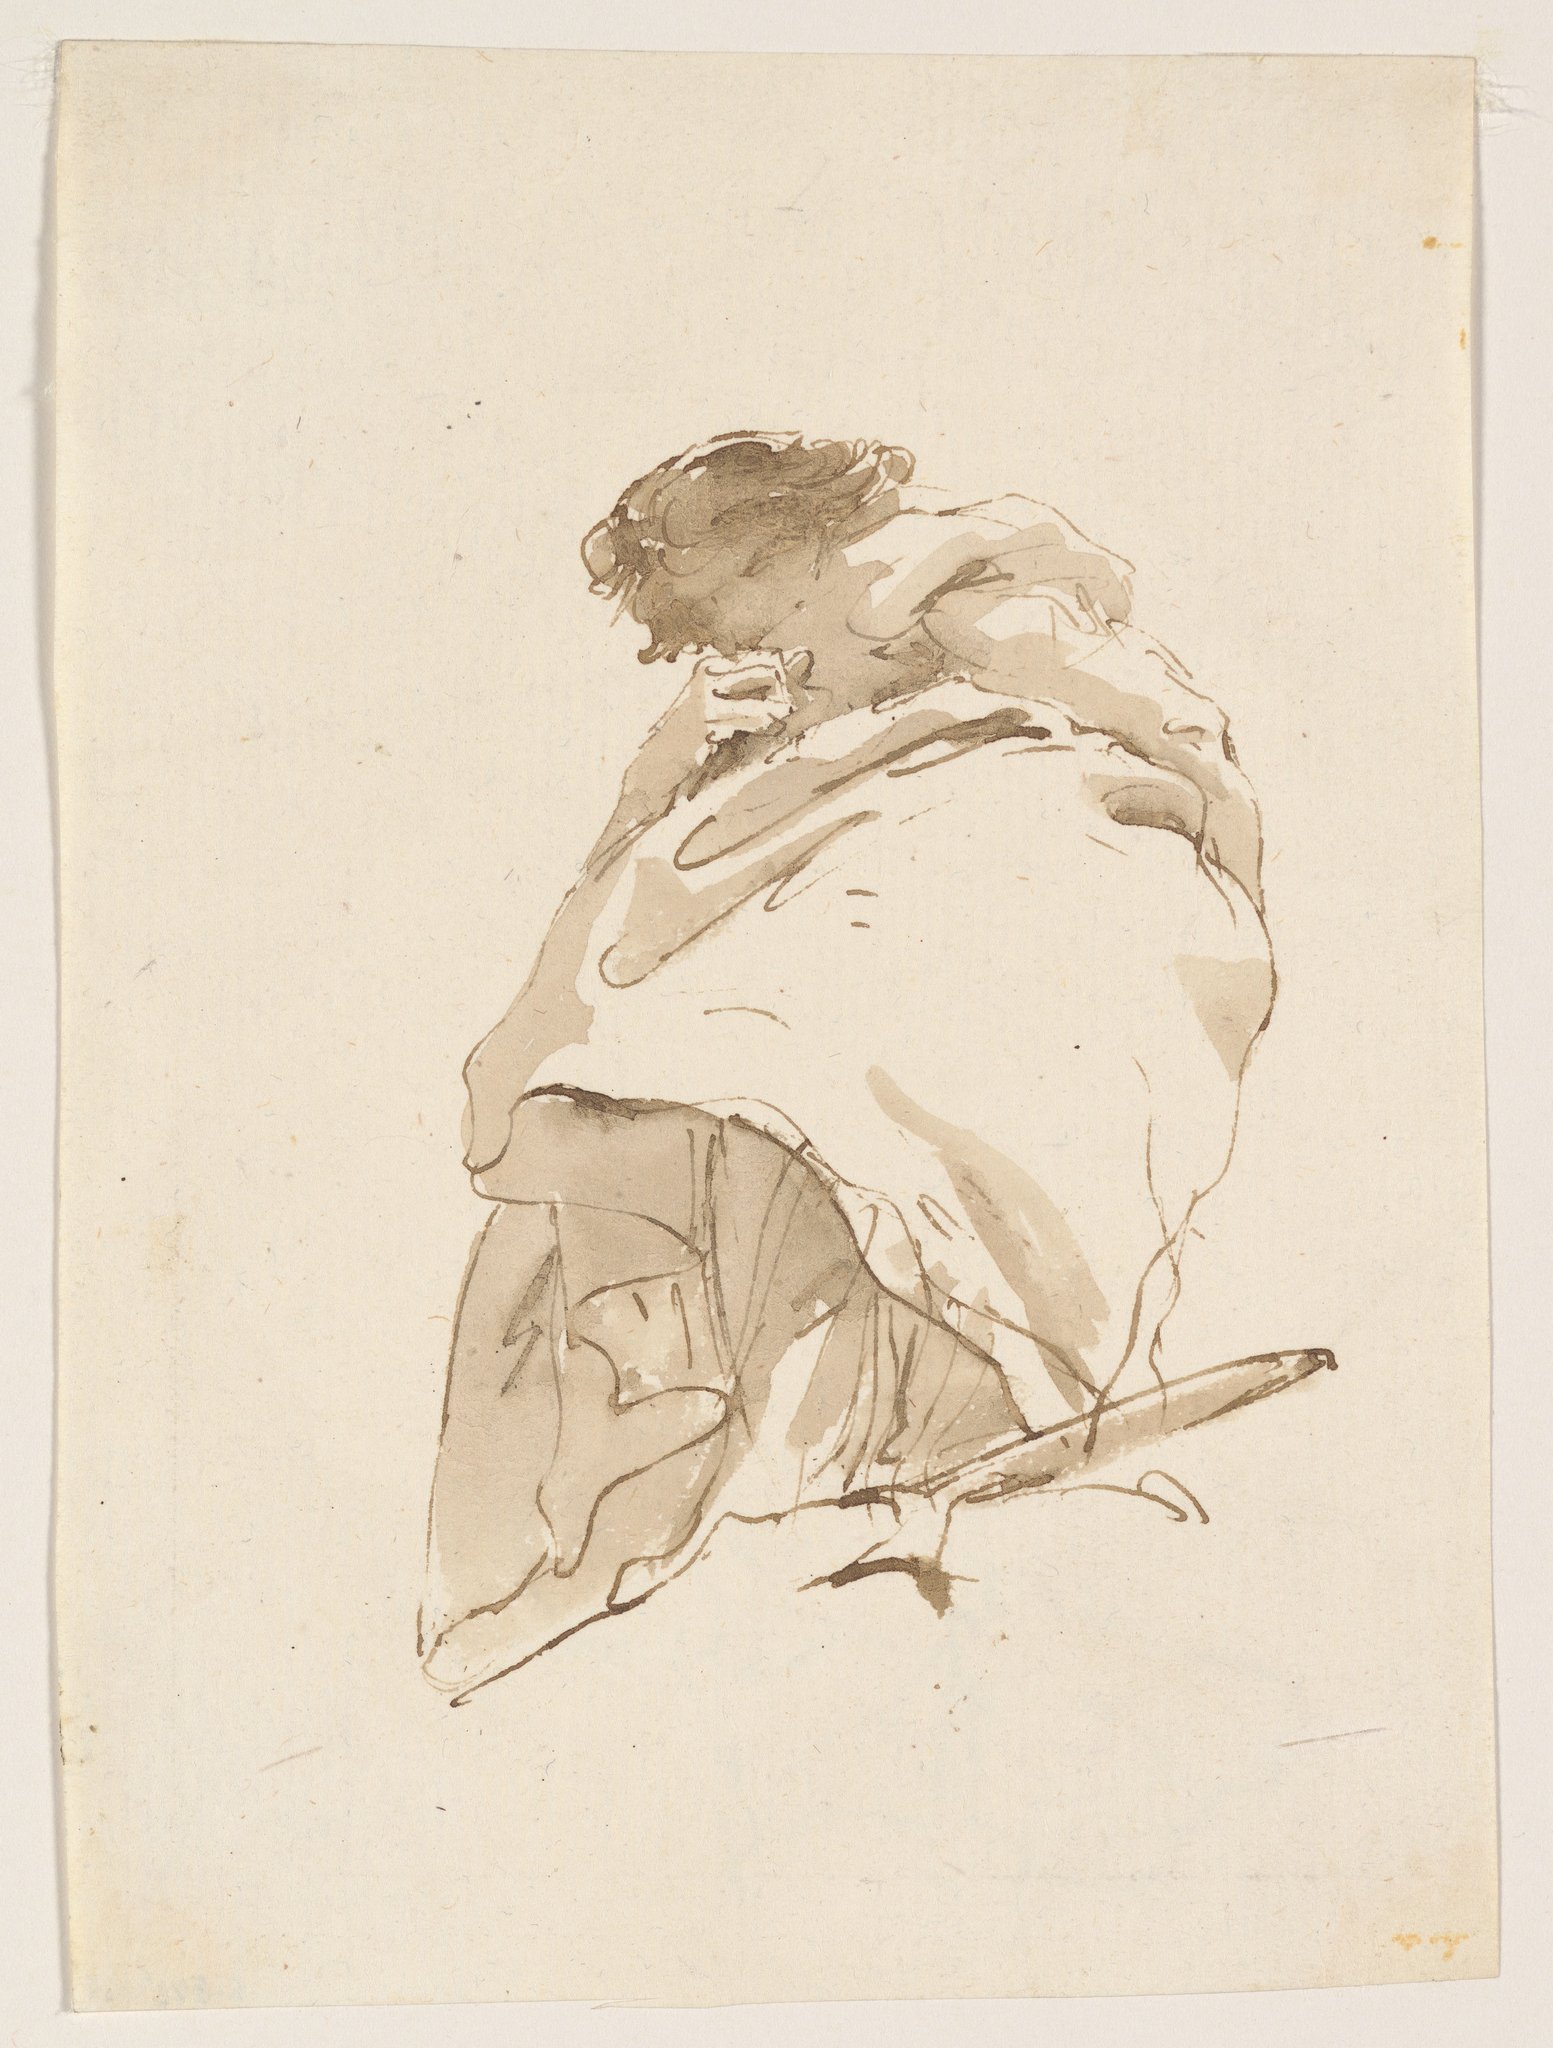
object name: drawing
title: Standing Woman, Turned to the Left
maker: giovanni battista tiepolo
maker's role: artist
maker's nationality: italian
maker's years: 1696-1770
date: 1742-1757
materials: ink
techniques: pen, wash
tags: women